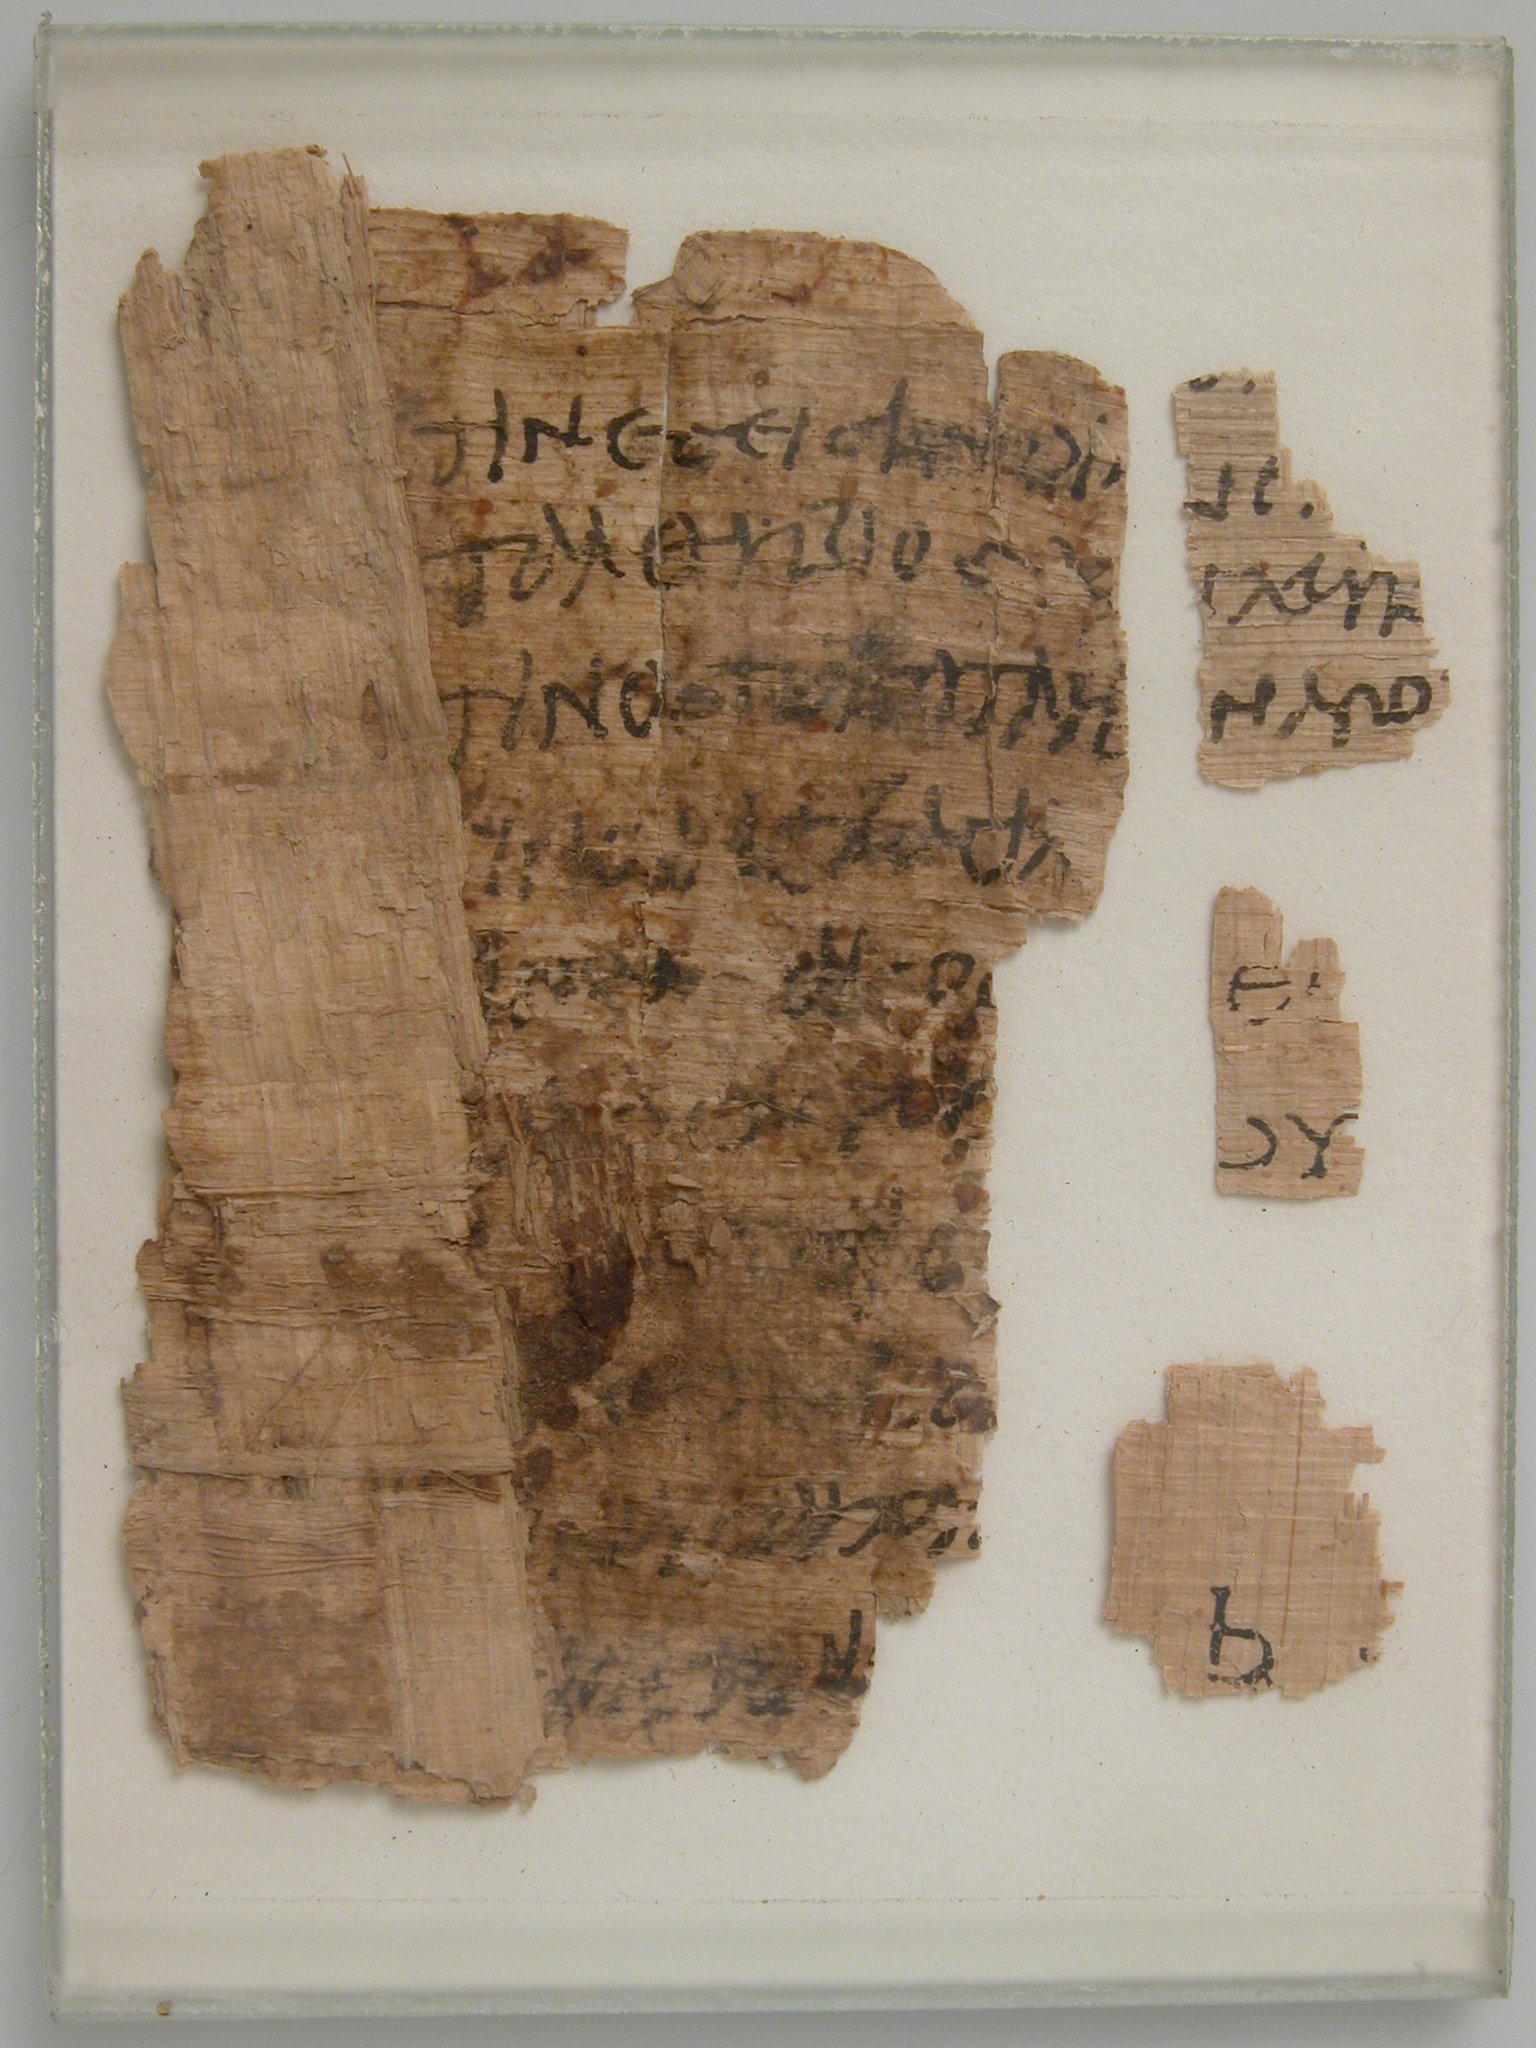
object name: fragment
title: Papyrus Fragments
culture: coptic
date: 301-700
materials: ink, papyrus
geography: egypt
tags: documents